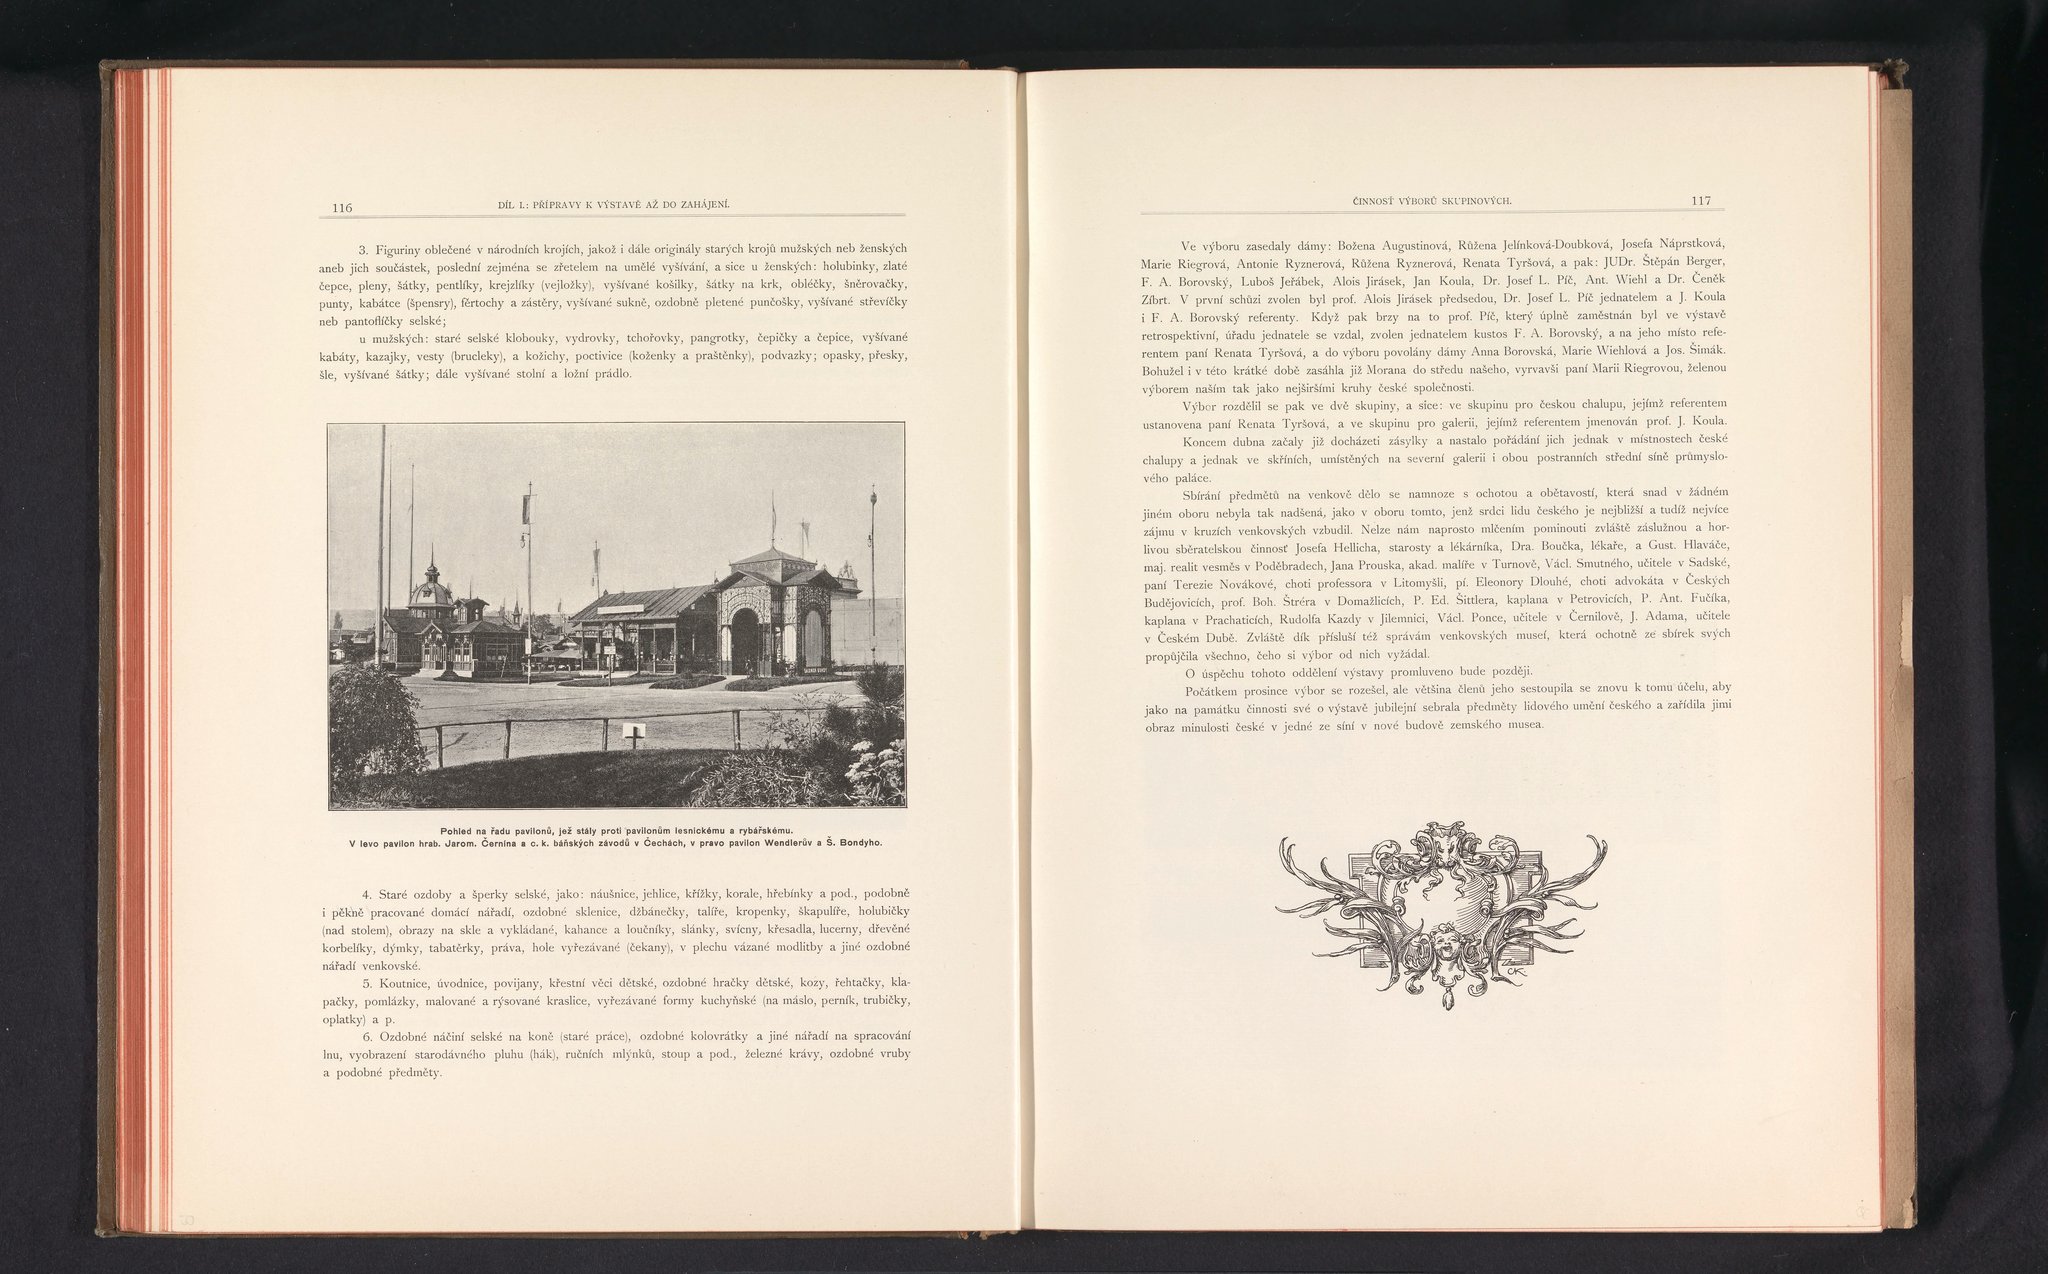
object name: photomechanical print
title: Exterieur van een paviljoen te Praag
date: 1888-1893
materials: paper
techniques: autotype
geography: prague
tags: façade (of house or building), temporary exhibition, 'salon'